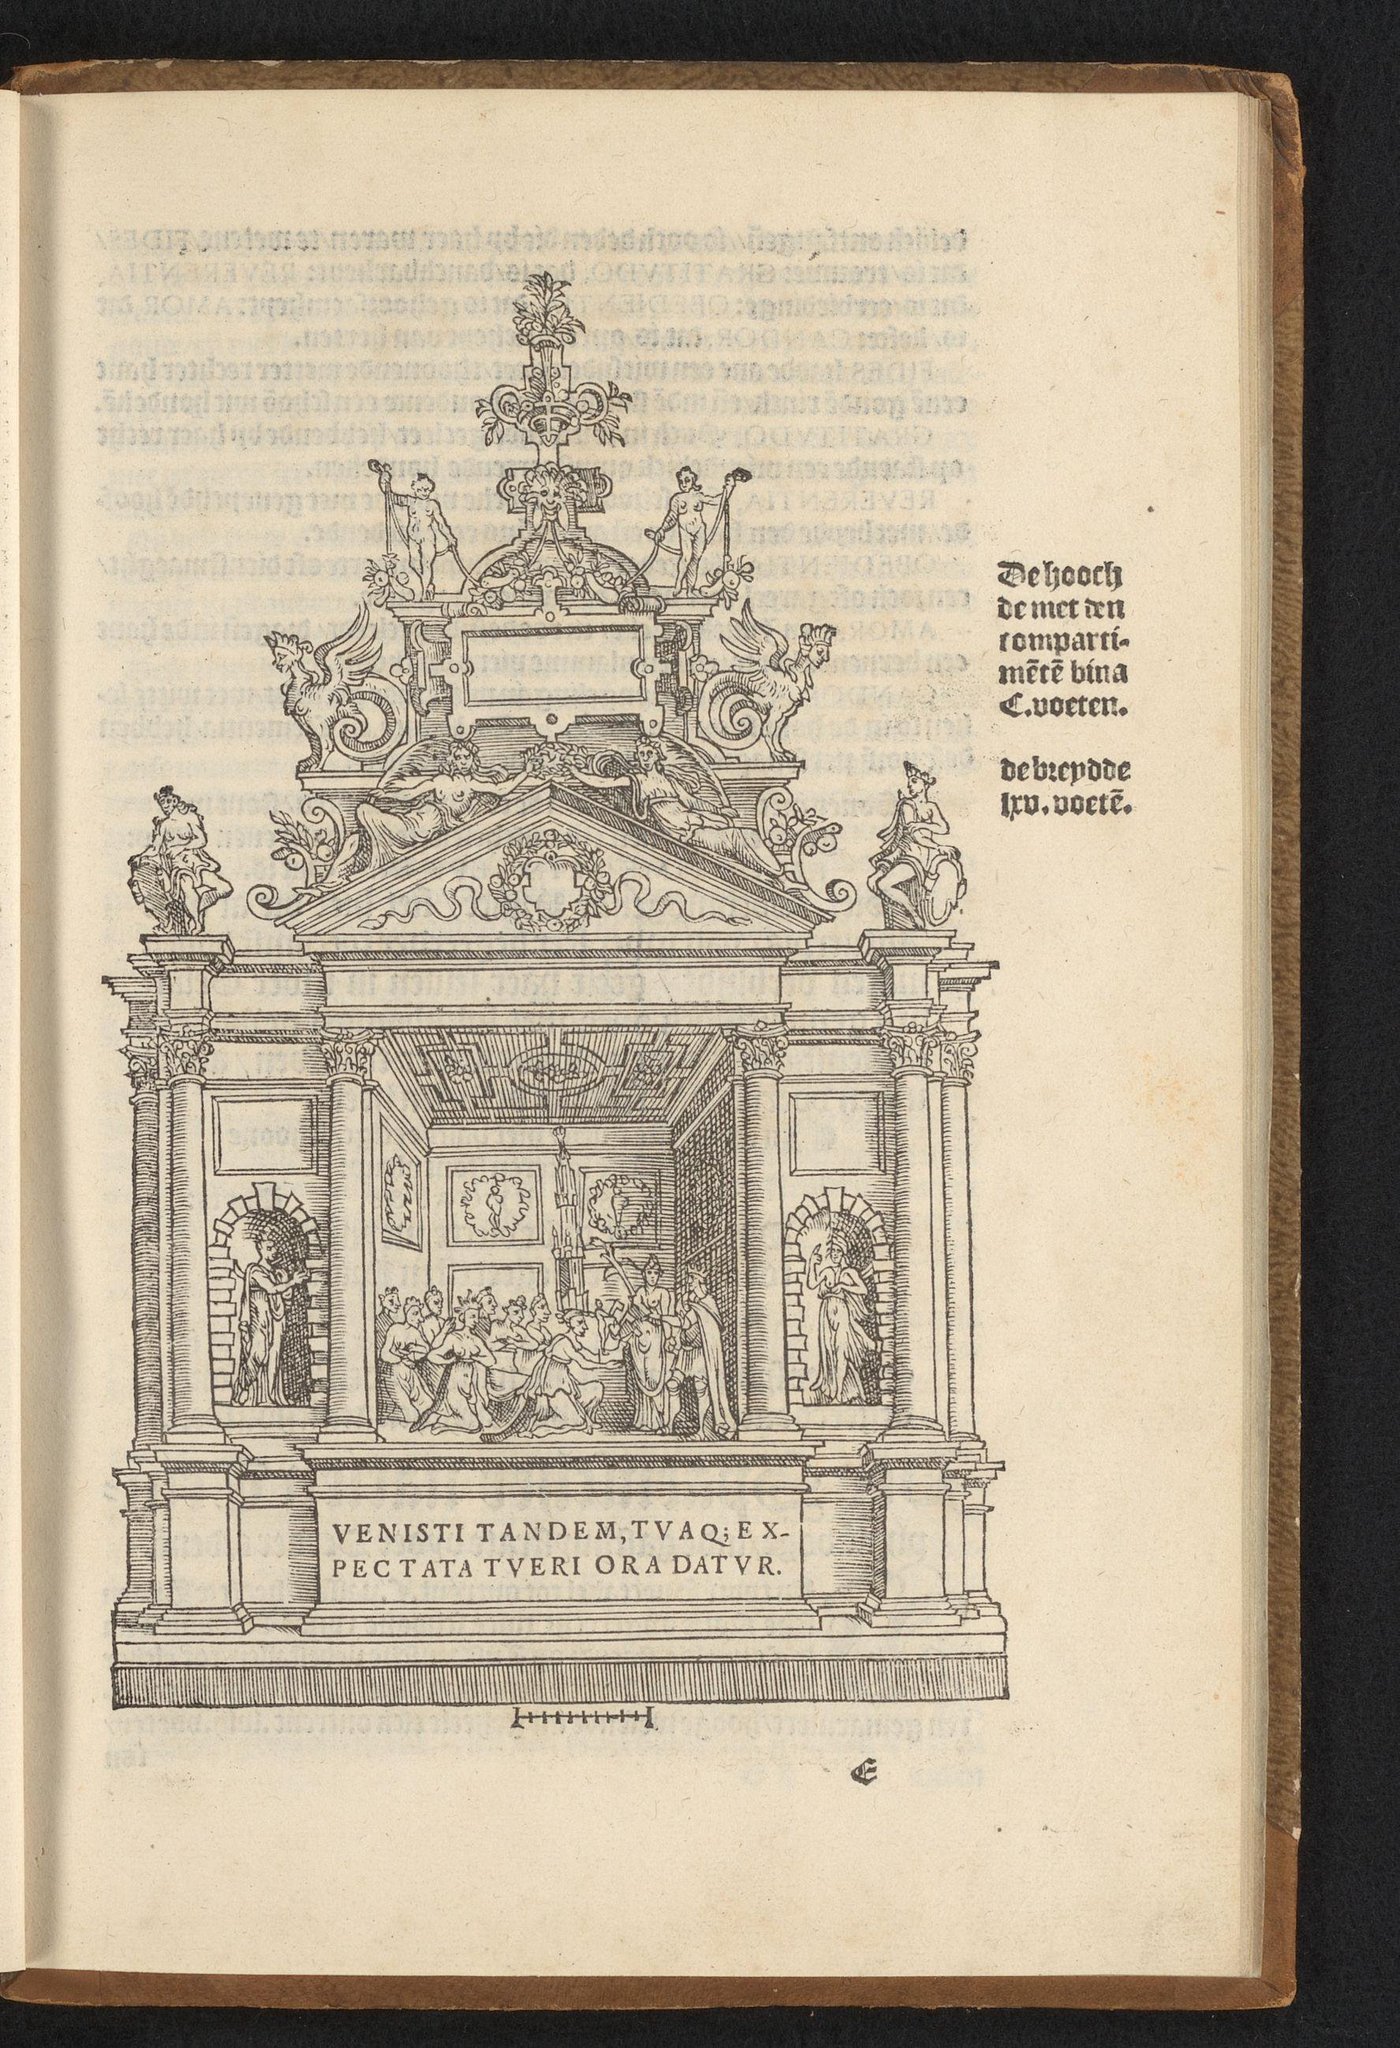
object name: print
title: Het tableau met de stad Antwerpen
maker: pieter coecke van aelst (i)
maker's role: draughtsman, print maker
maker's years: 1502-1550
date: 1549-1550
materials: paper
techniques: woodcut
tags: philip ii of spain, 'tableau vivant', triumphal arch, antwerp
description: Illustratie in de Nederlandse vertaling van de beschrijving van de intocht van Filips II in Antwerpen in 1549: De seer wonderlijcke schoone triumphelijcke incompst, van den hooghmogenden Prince Philips, Prince van Spaignen, Caroli des vijfden, Keysers sone : inde stadt van Antwerpen, Anno 1549. Tekst van Cornelius Grapheus, waarschijnlijk vertaald uit het Latijn door Gillis van Diest, opgedragen aan Filips II, uitgegeven met keizerlijke privilege door Pieter Coecke van Aelst, gedrukt door Gillis van Diest. Boek in de bibliotheek met signatuur: 325 B 12.